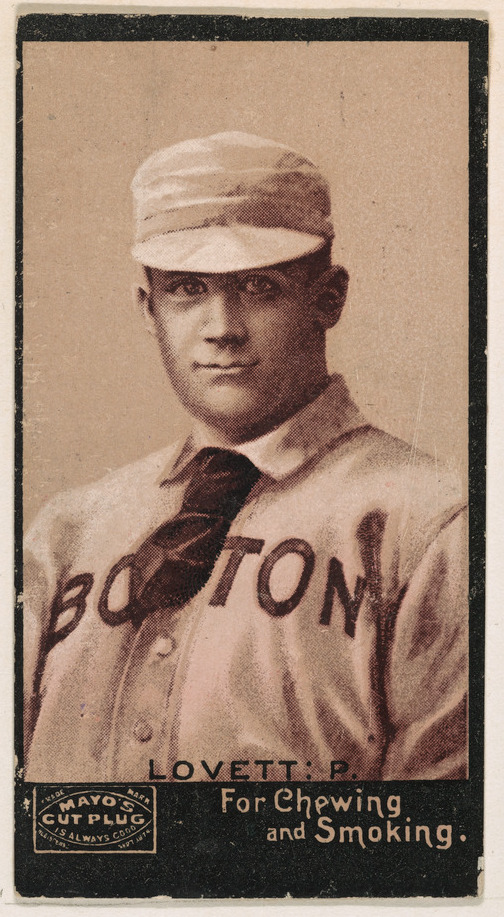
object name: print, baseball card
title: Lovett, Pitcher, Boston, from Mayo's Cut Plug Baseball series (N300)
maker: p.h. mayo & brother, richmond, virginia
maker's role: publisher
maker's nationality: american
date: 1895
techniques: lithography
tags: men,portraits,baseball,athletes